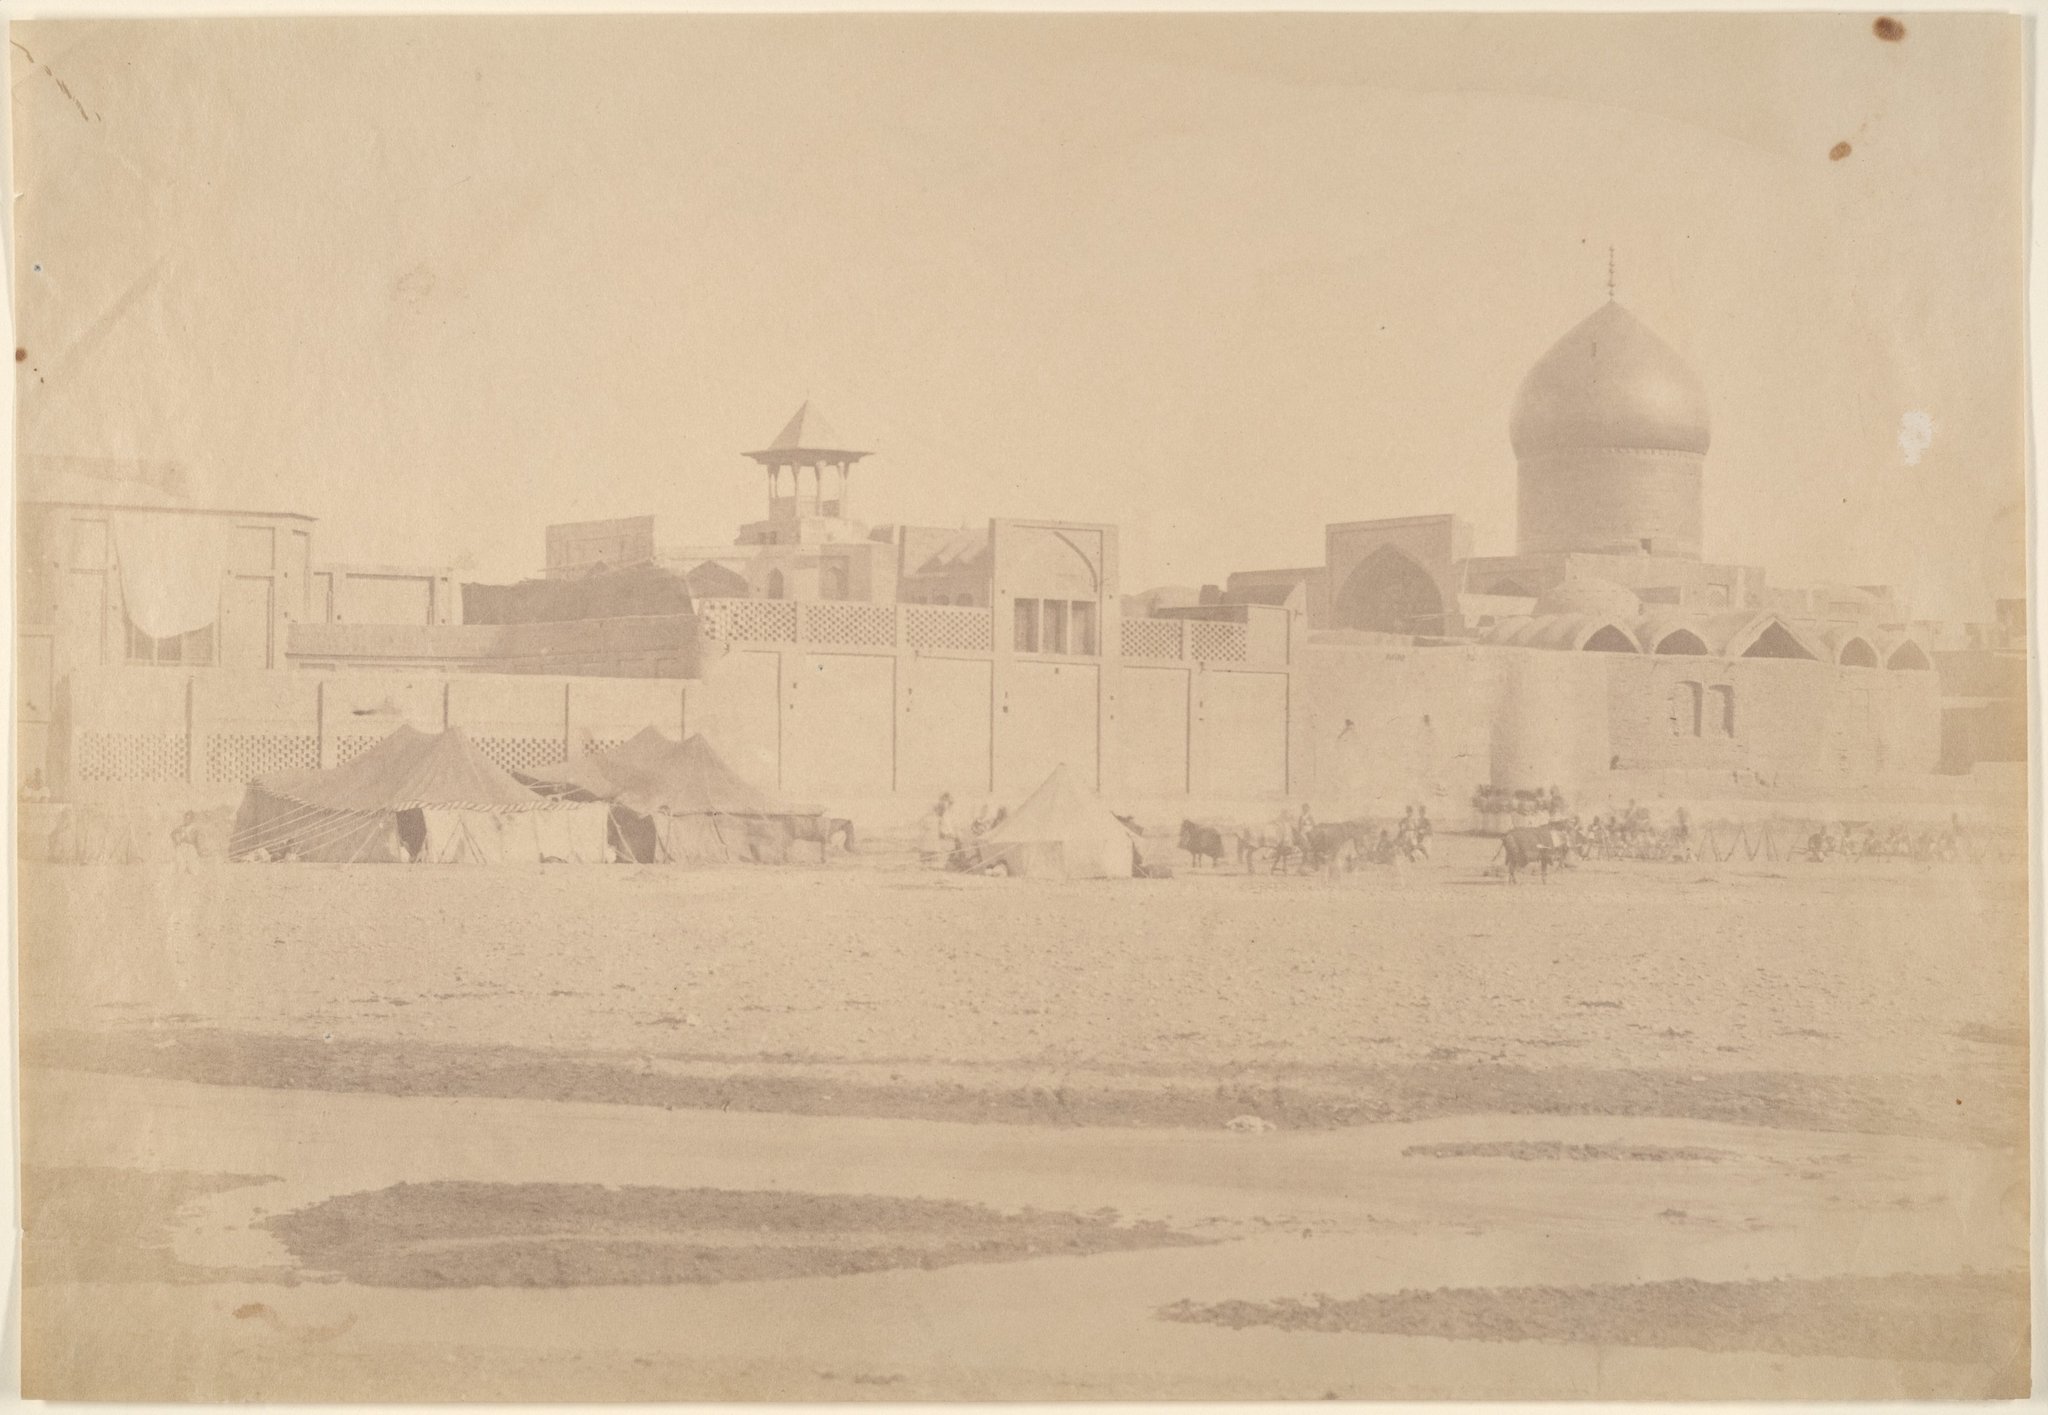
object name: photograph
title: [View of Koum]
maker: luigi pesce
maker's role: artist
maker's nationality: italian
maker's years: 1818-1891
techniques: albumen silver print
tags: architecture,buildings